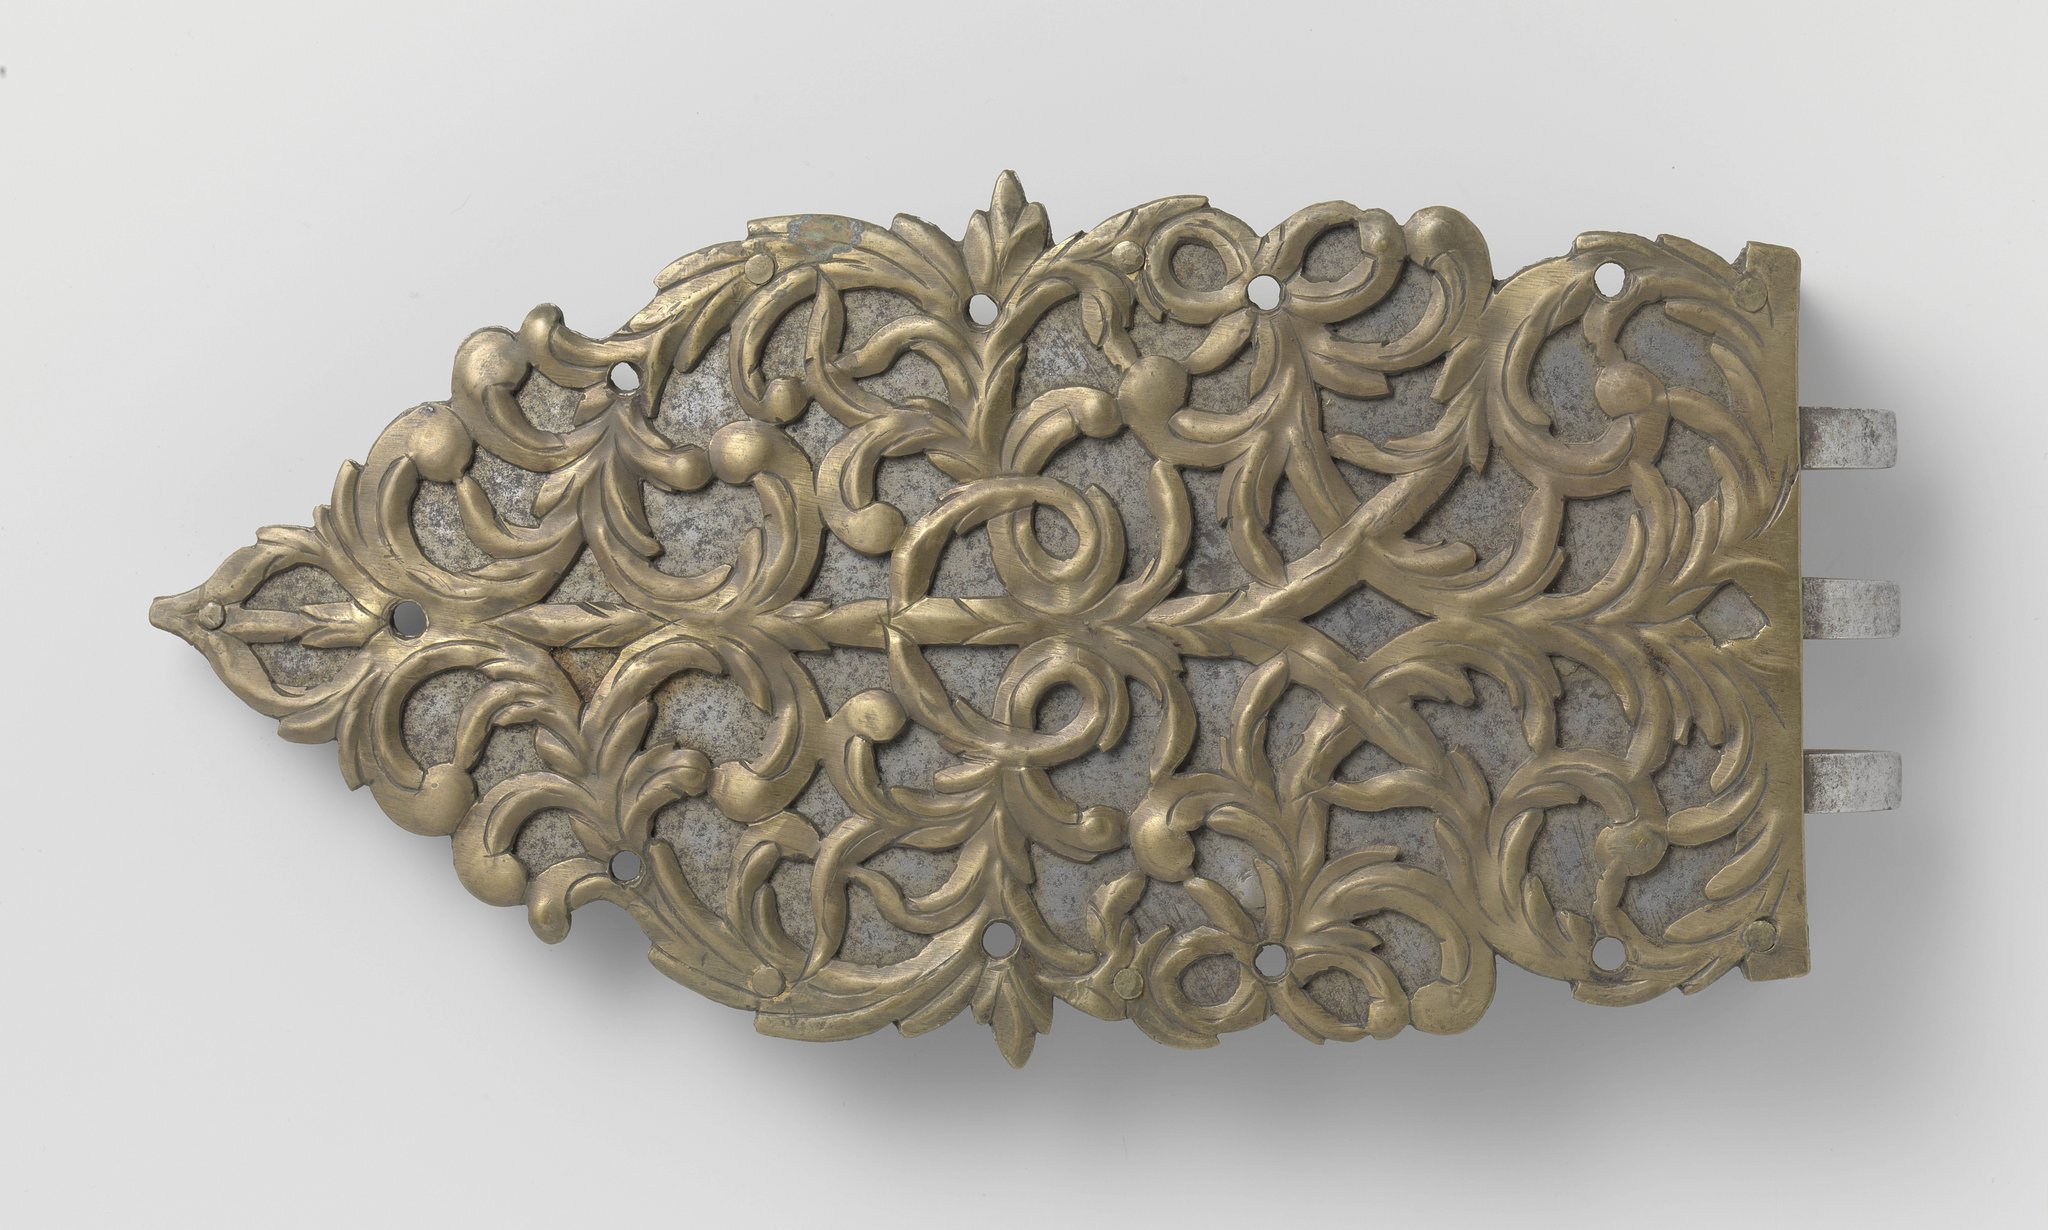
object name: lock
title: Slot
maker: Anonymous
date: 1650-1700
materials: copper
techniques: embroidery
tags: ornament derived from plant forms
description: Een slot met fraai opengewerkte koperen dekplaat.